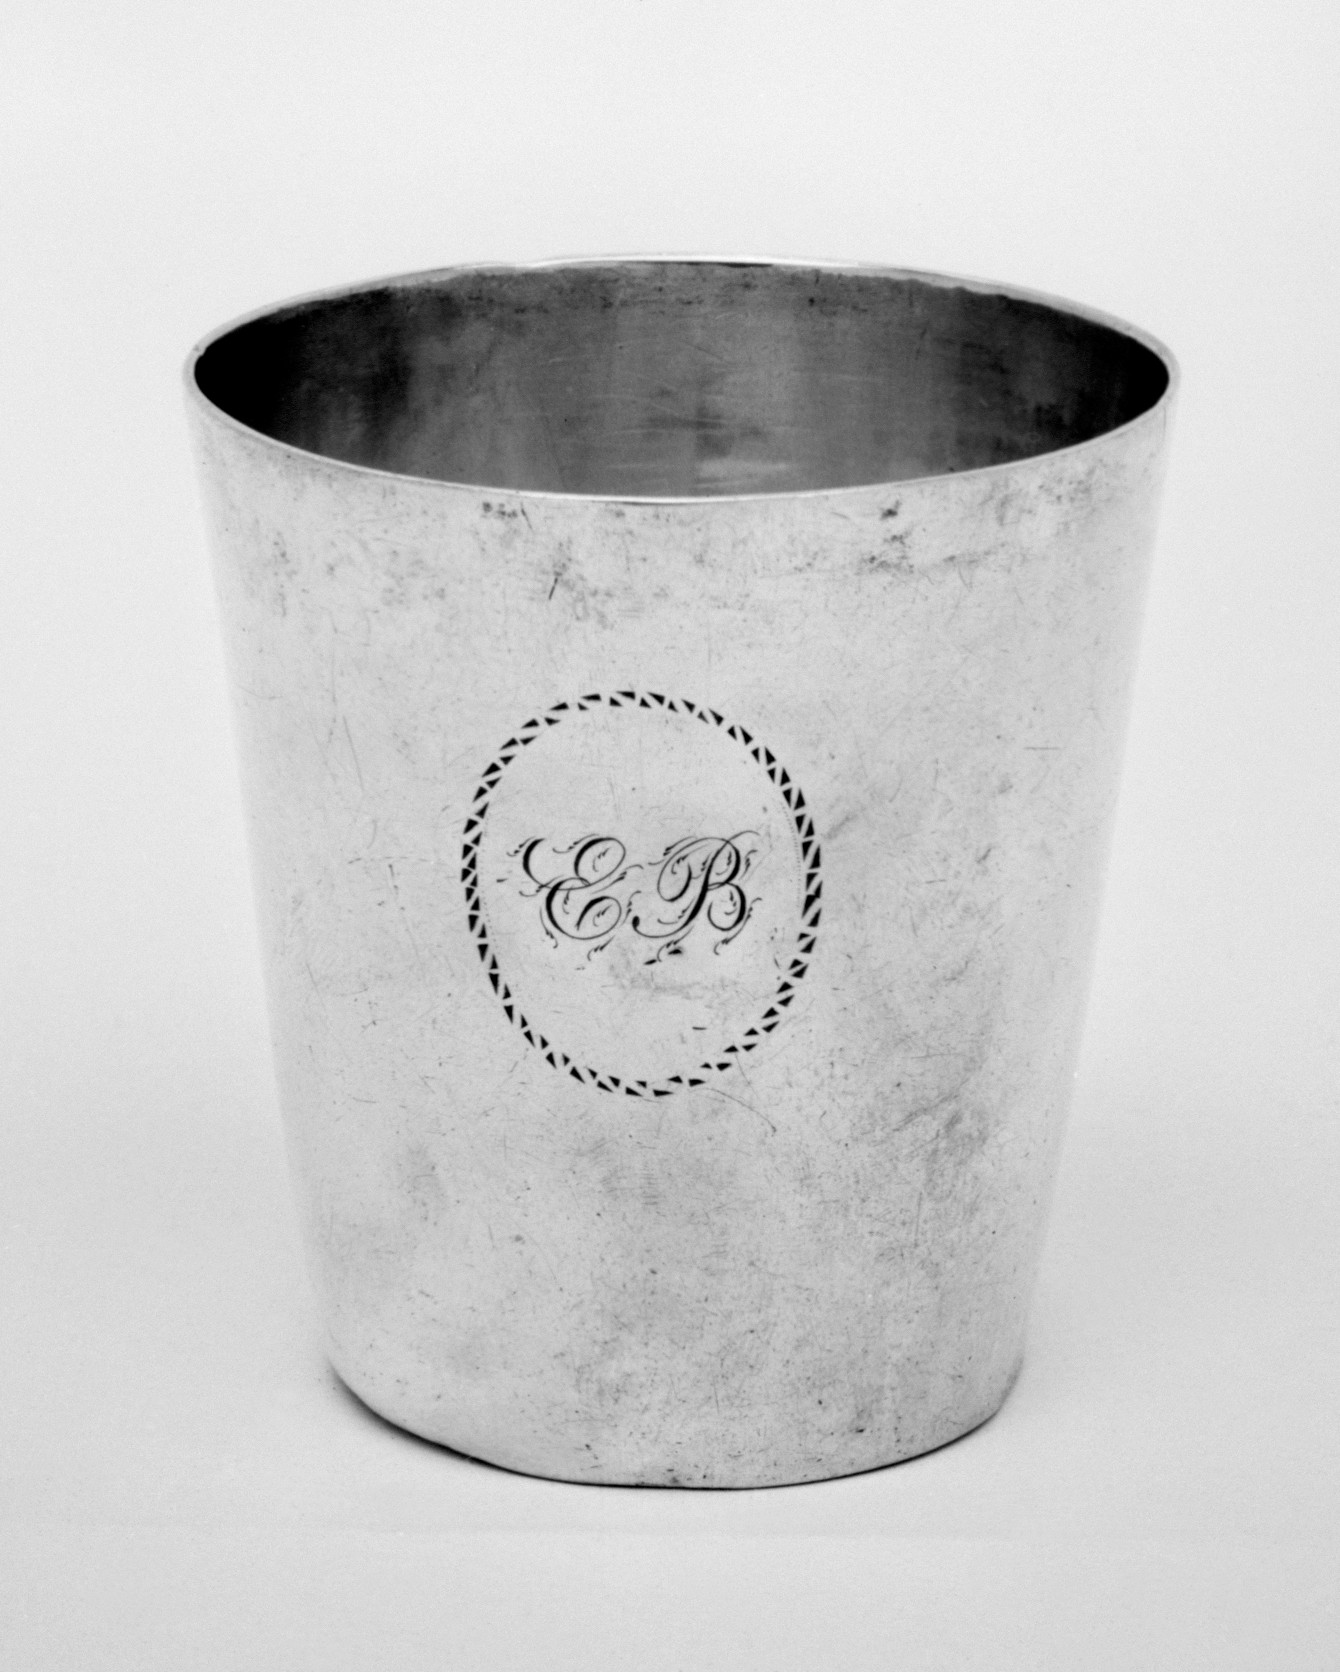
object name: beaker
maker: l. a.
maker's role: maker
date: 1767-1800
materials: silver